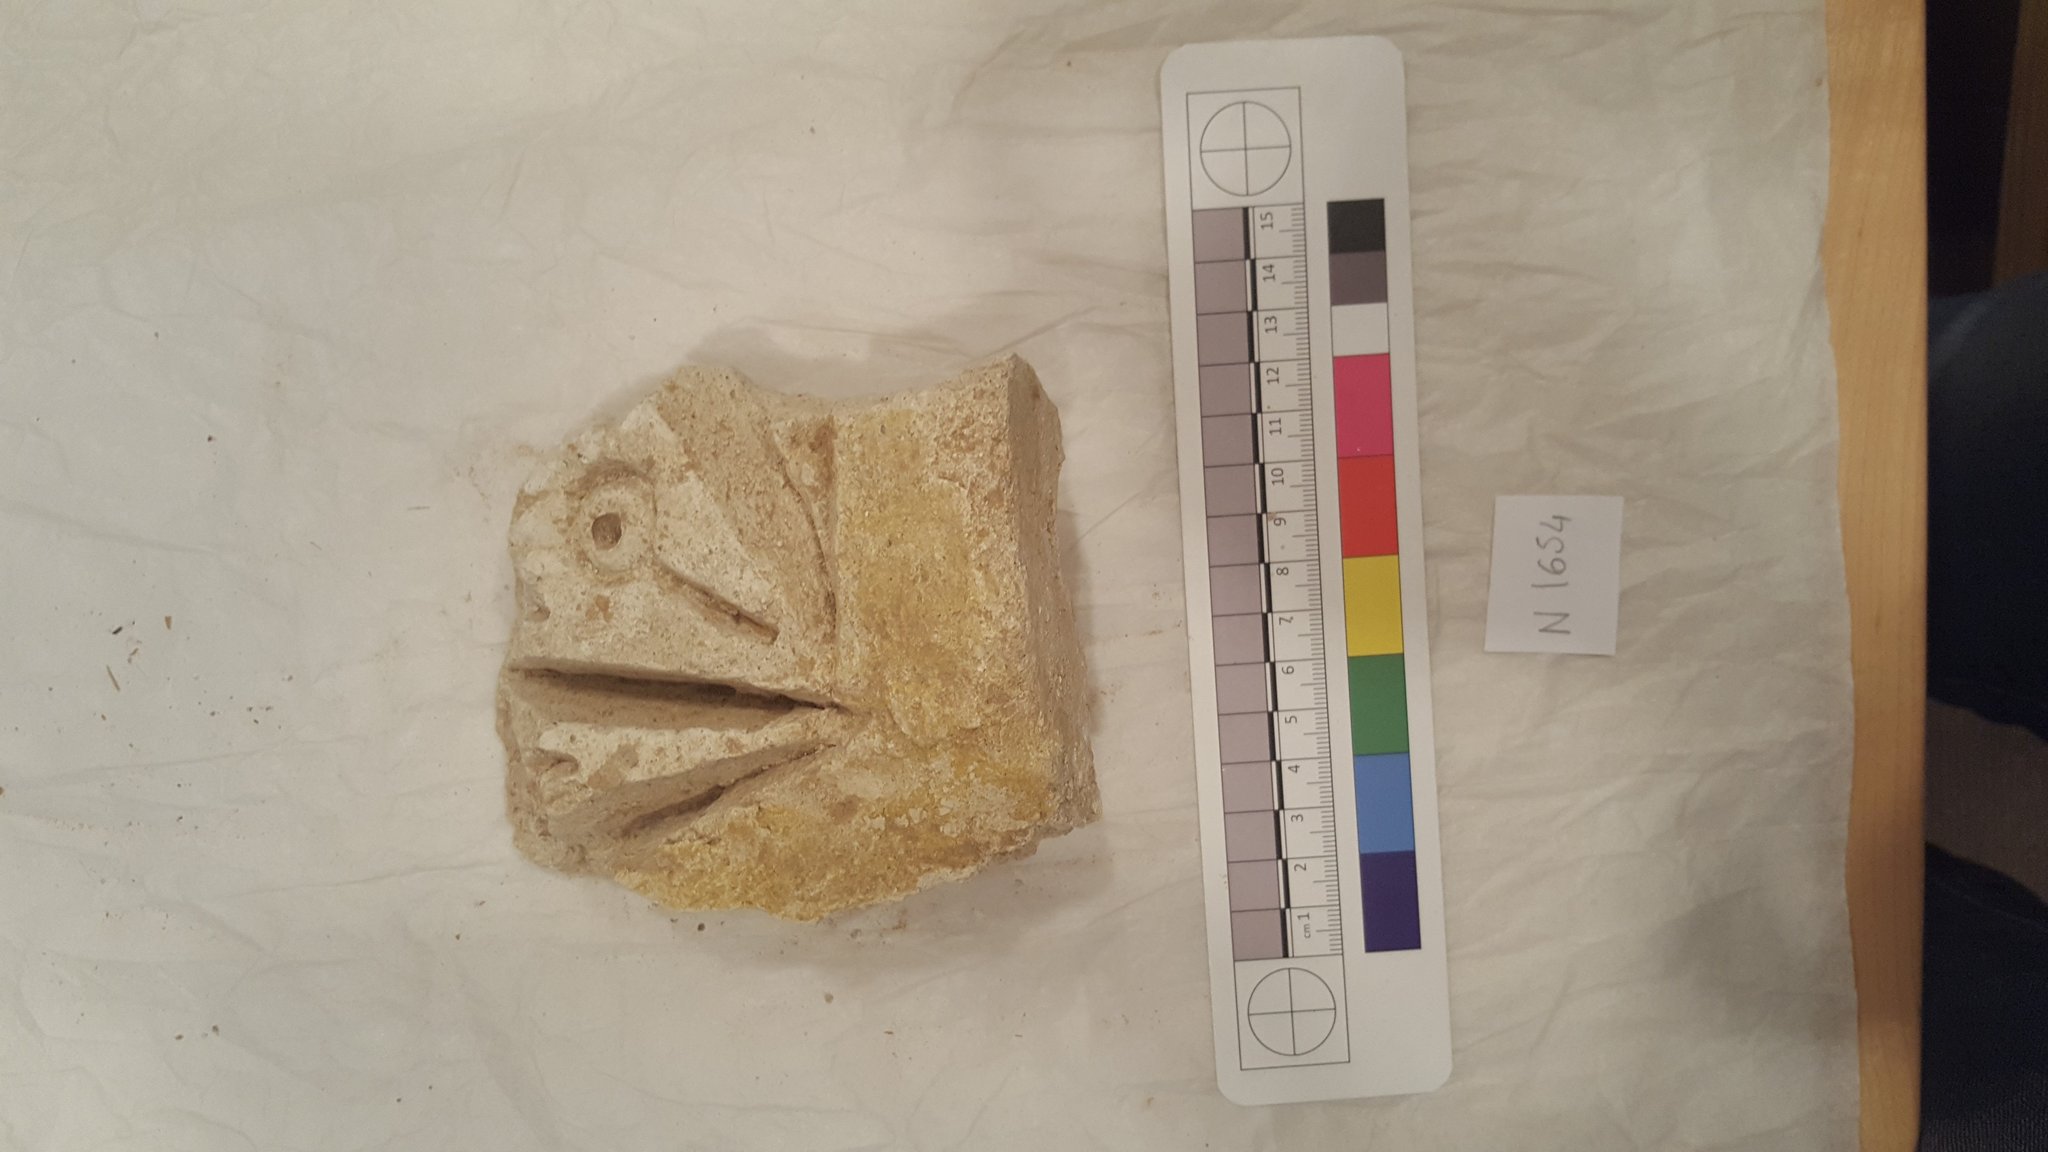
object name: fragment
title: Stucco Fragment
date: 701-1200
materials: plaster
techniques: carving, painting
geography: iran